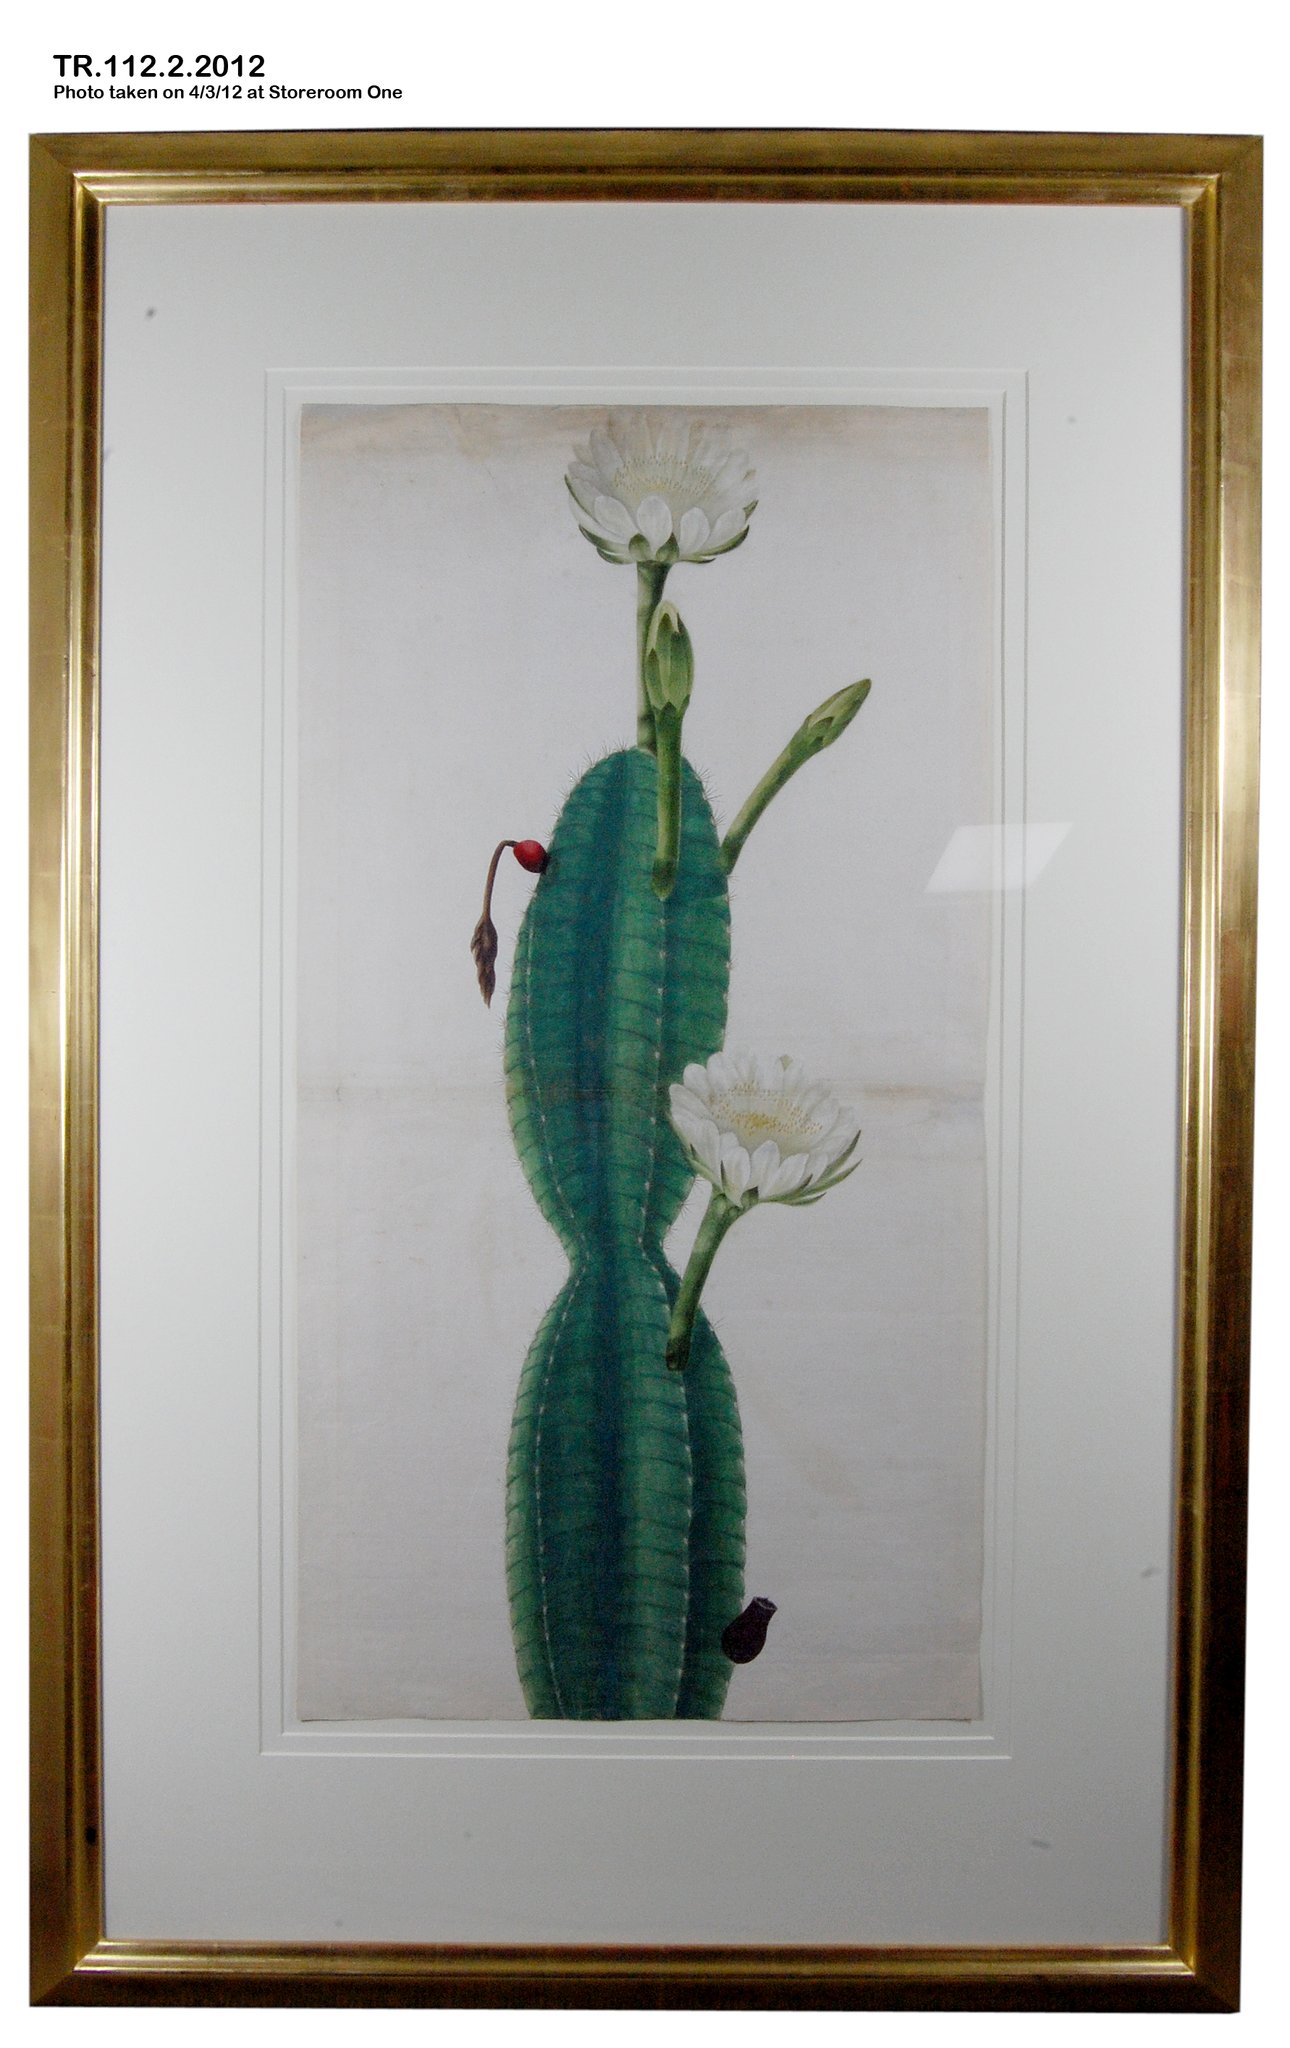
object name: painting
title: Cactus Plant in Flower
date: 1800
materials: paper, watercolor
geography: india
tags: flowers,plants